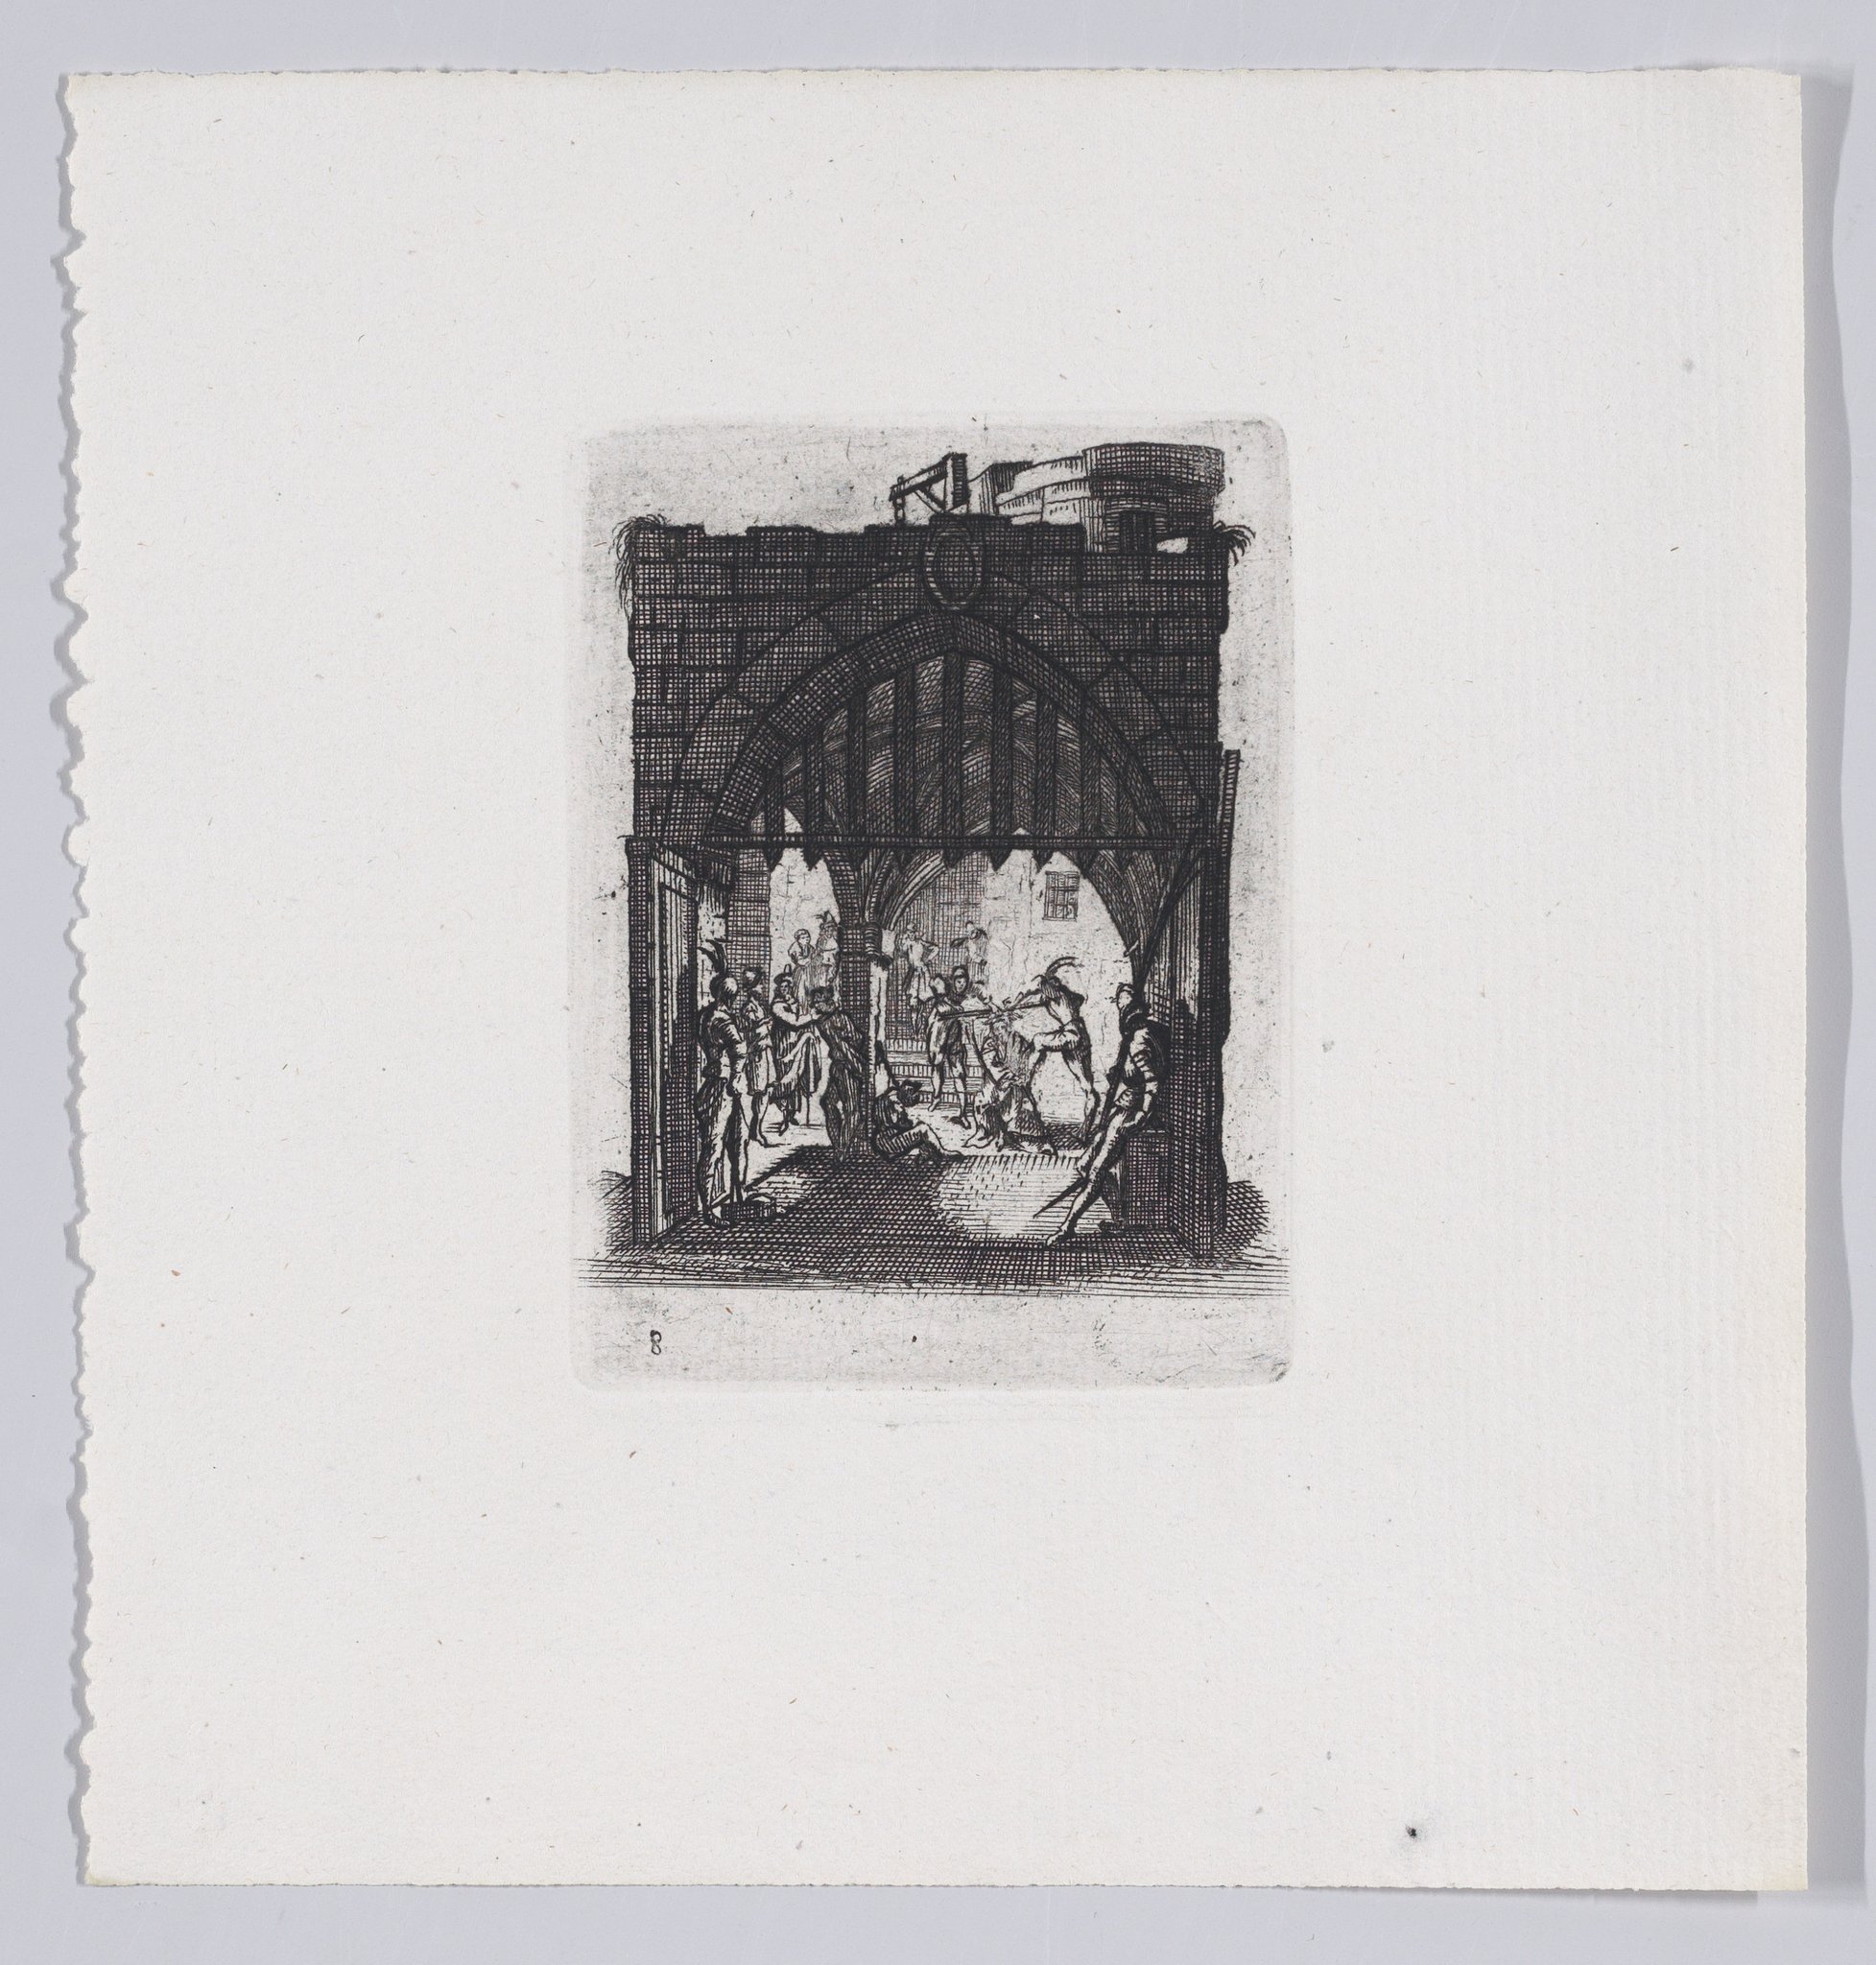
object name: print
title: Reverse Copy of Le Couronnement d'Épines (The Crowning with Thornes), from La Petite Passion (The Little Passion)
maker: Anonymous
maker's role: artist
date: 1601-1700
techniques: etching